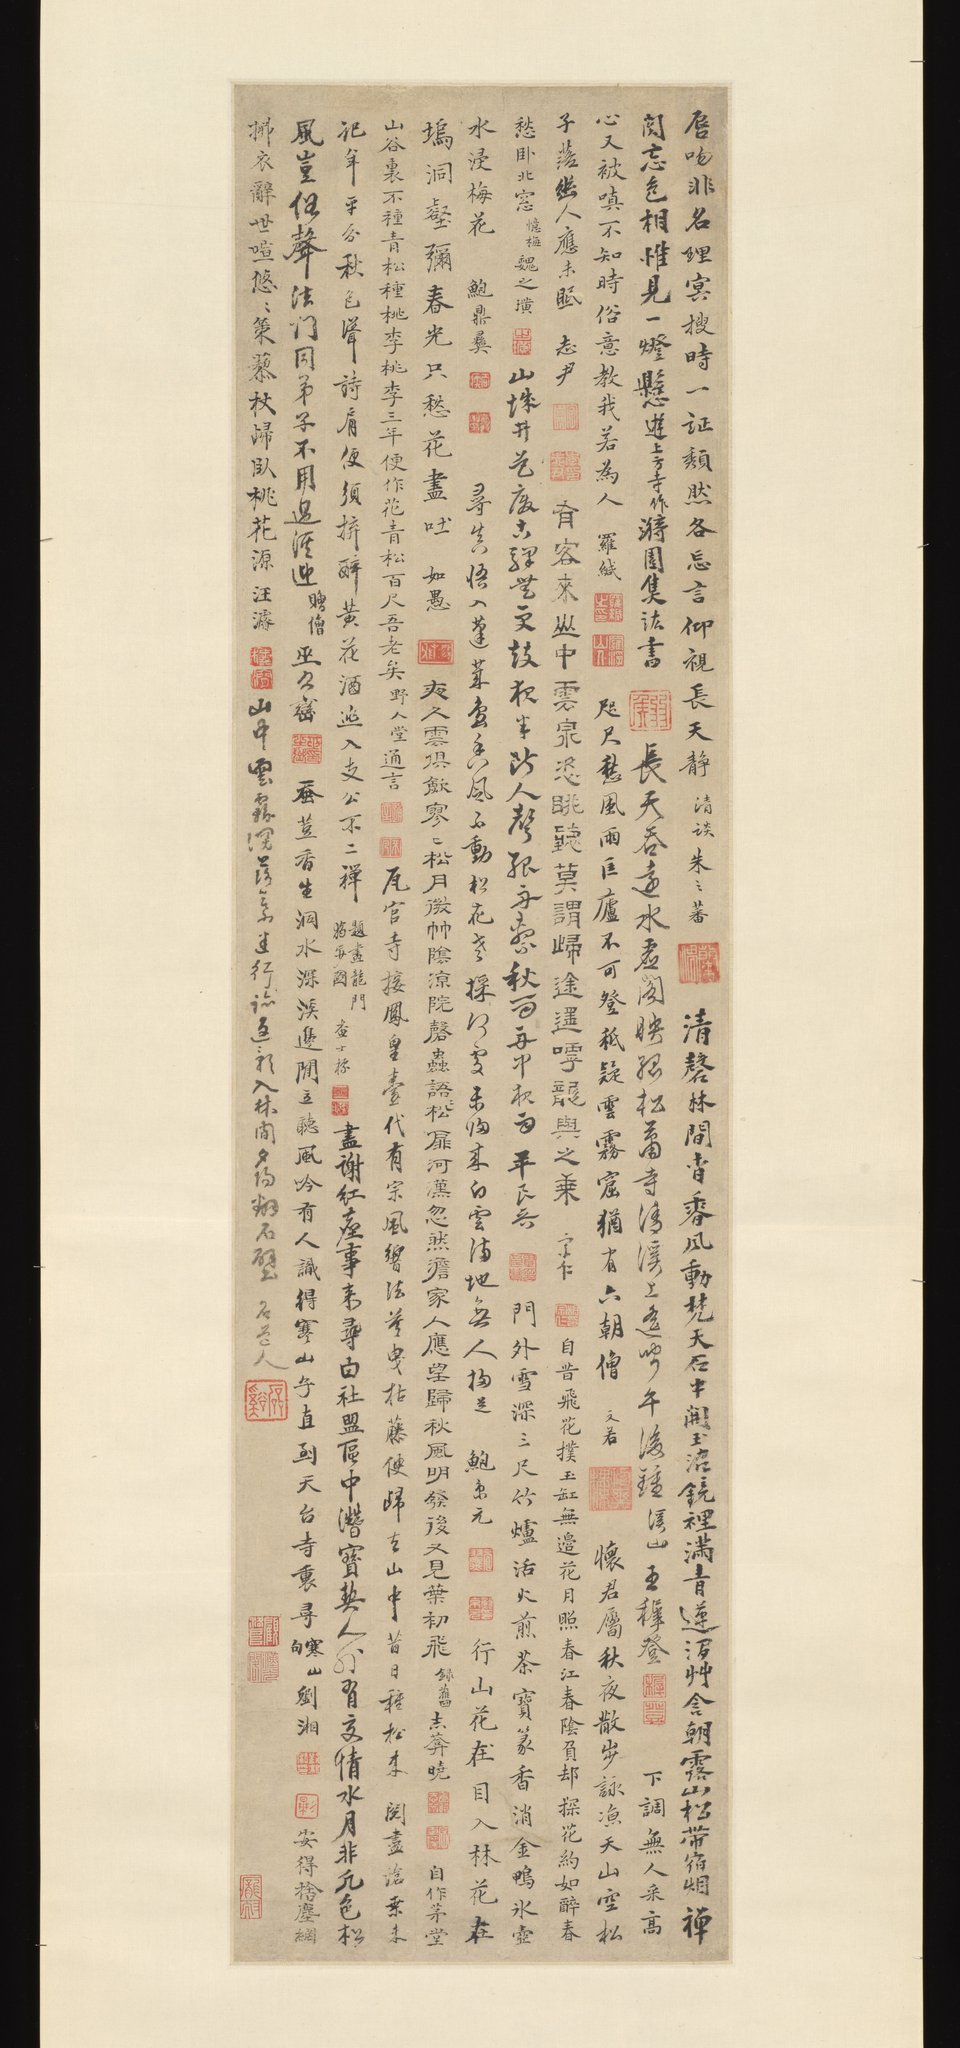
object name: hanging scroll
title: Poems by Famous Literati in Nanjing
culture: chinese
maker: liu xiang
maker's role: artist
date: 1501-1700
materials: ink, paper